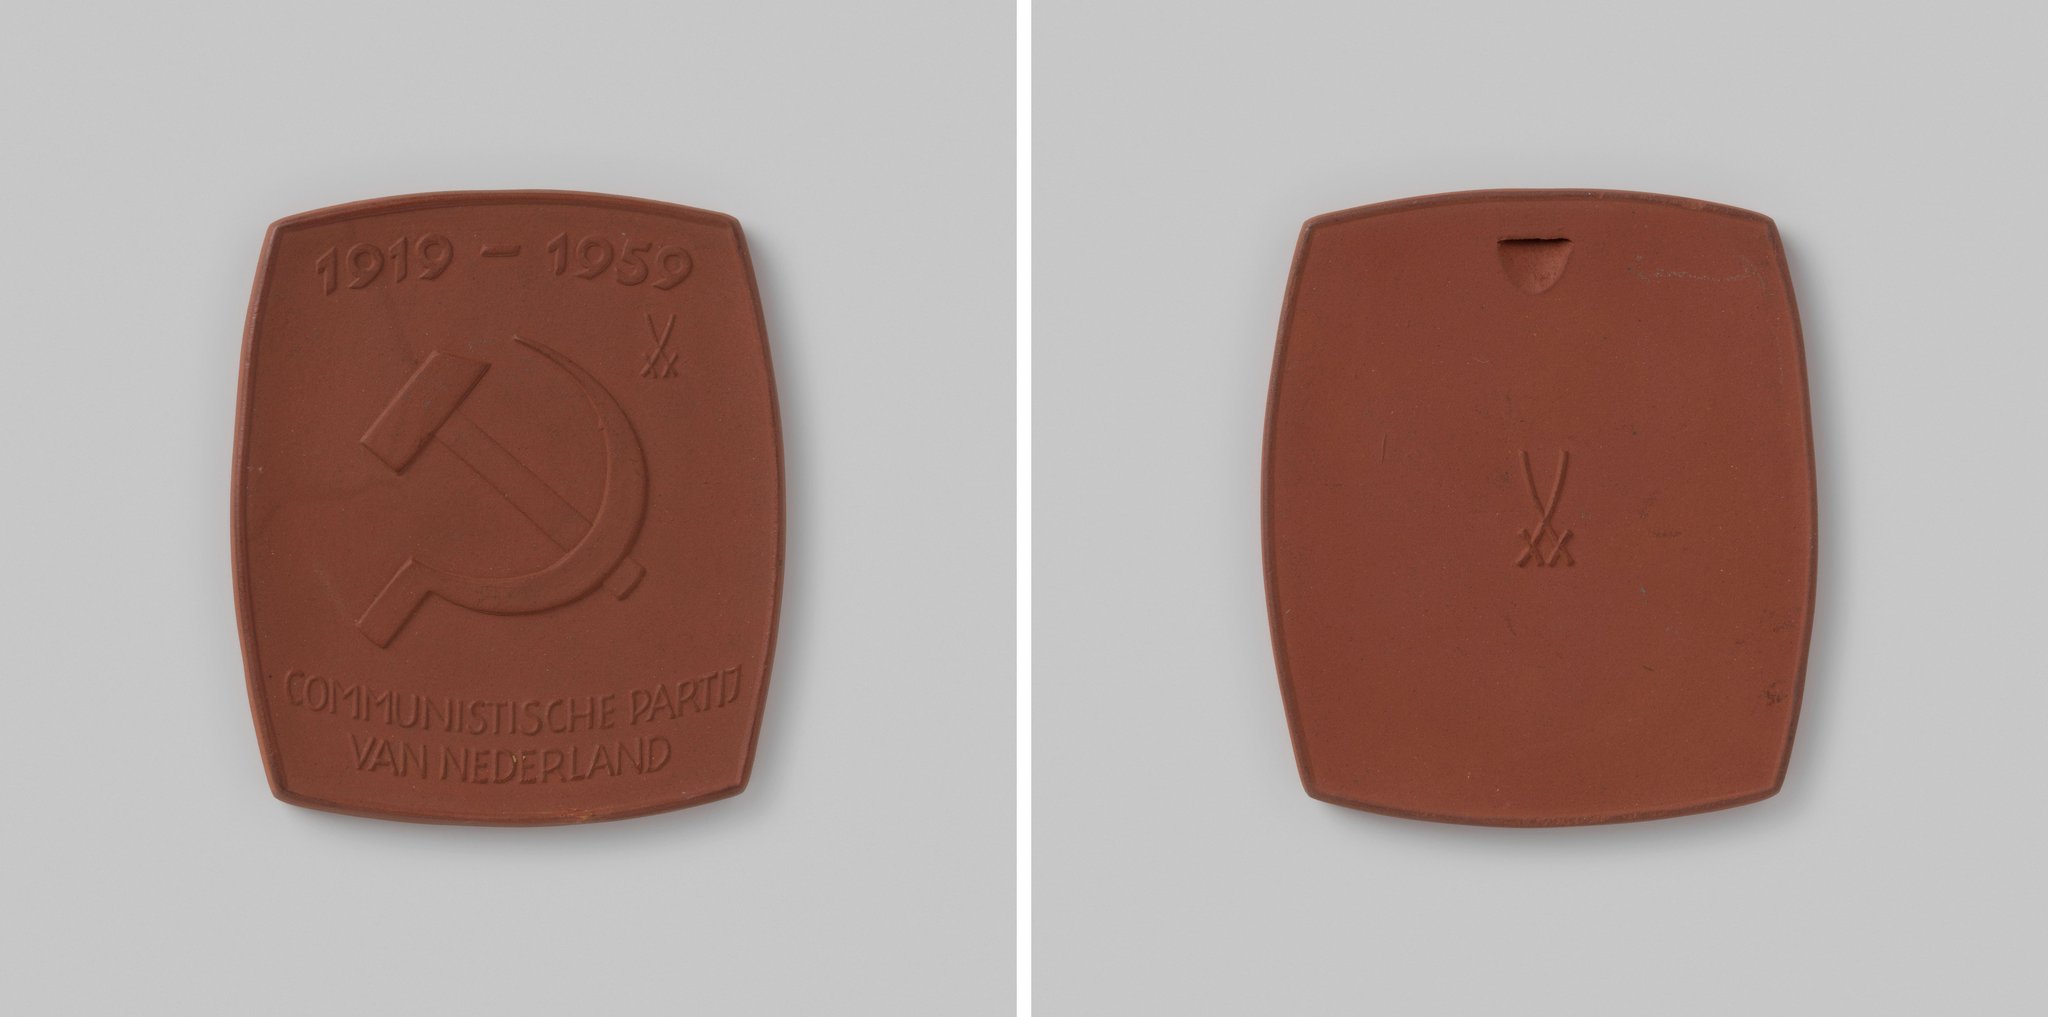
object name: commemorative plaque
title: Veertig jaar CPN (Communistische Partij van Nederland), 1959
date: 1959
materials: stoneware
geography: meissen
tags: netherlands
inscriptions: factory mark, inscription: ‘1919-1959 / Communistische Partij van Nederland’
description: Staande, rechthoekige roodbruine steengoed plaquette met gebogen zijden. Voorzijde midden: hamer en sikkel (symbool Communistische Partij van Nederland); boven: jaartallen en fabrieksmerk, onder tekst. Keerzijde ophanggaatje en merkteken.